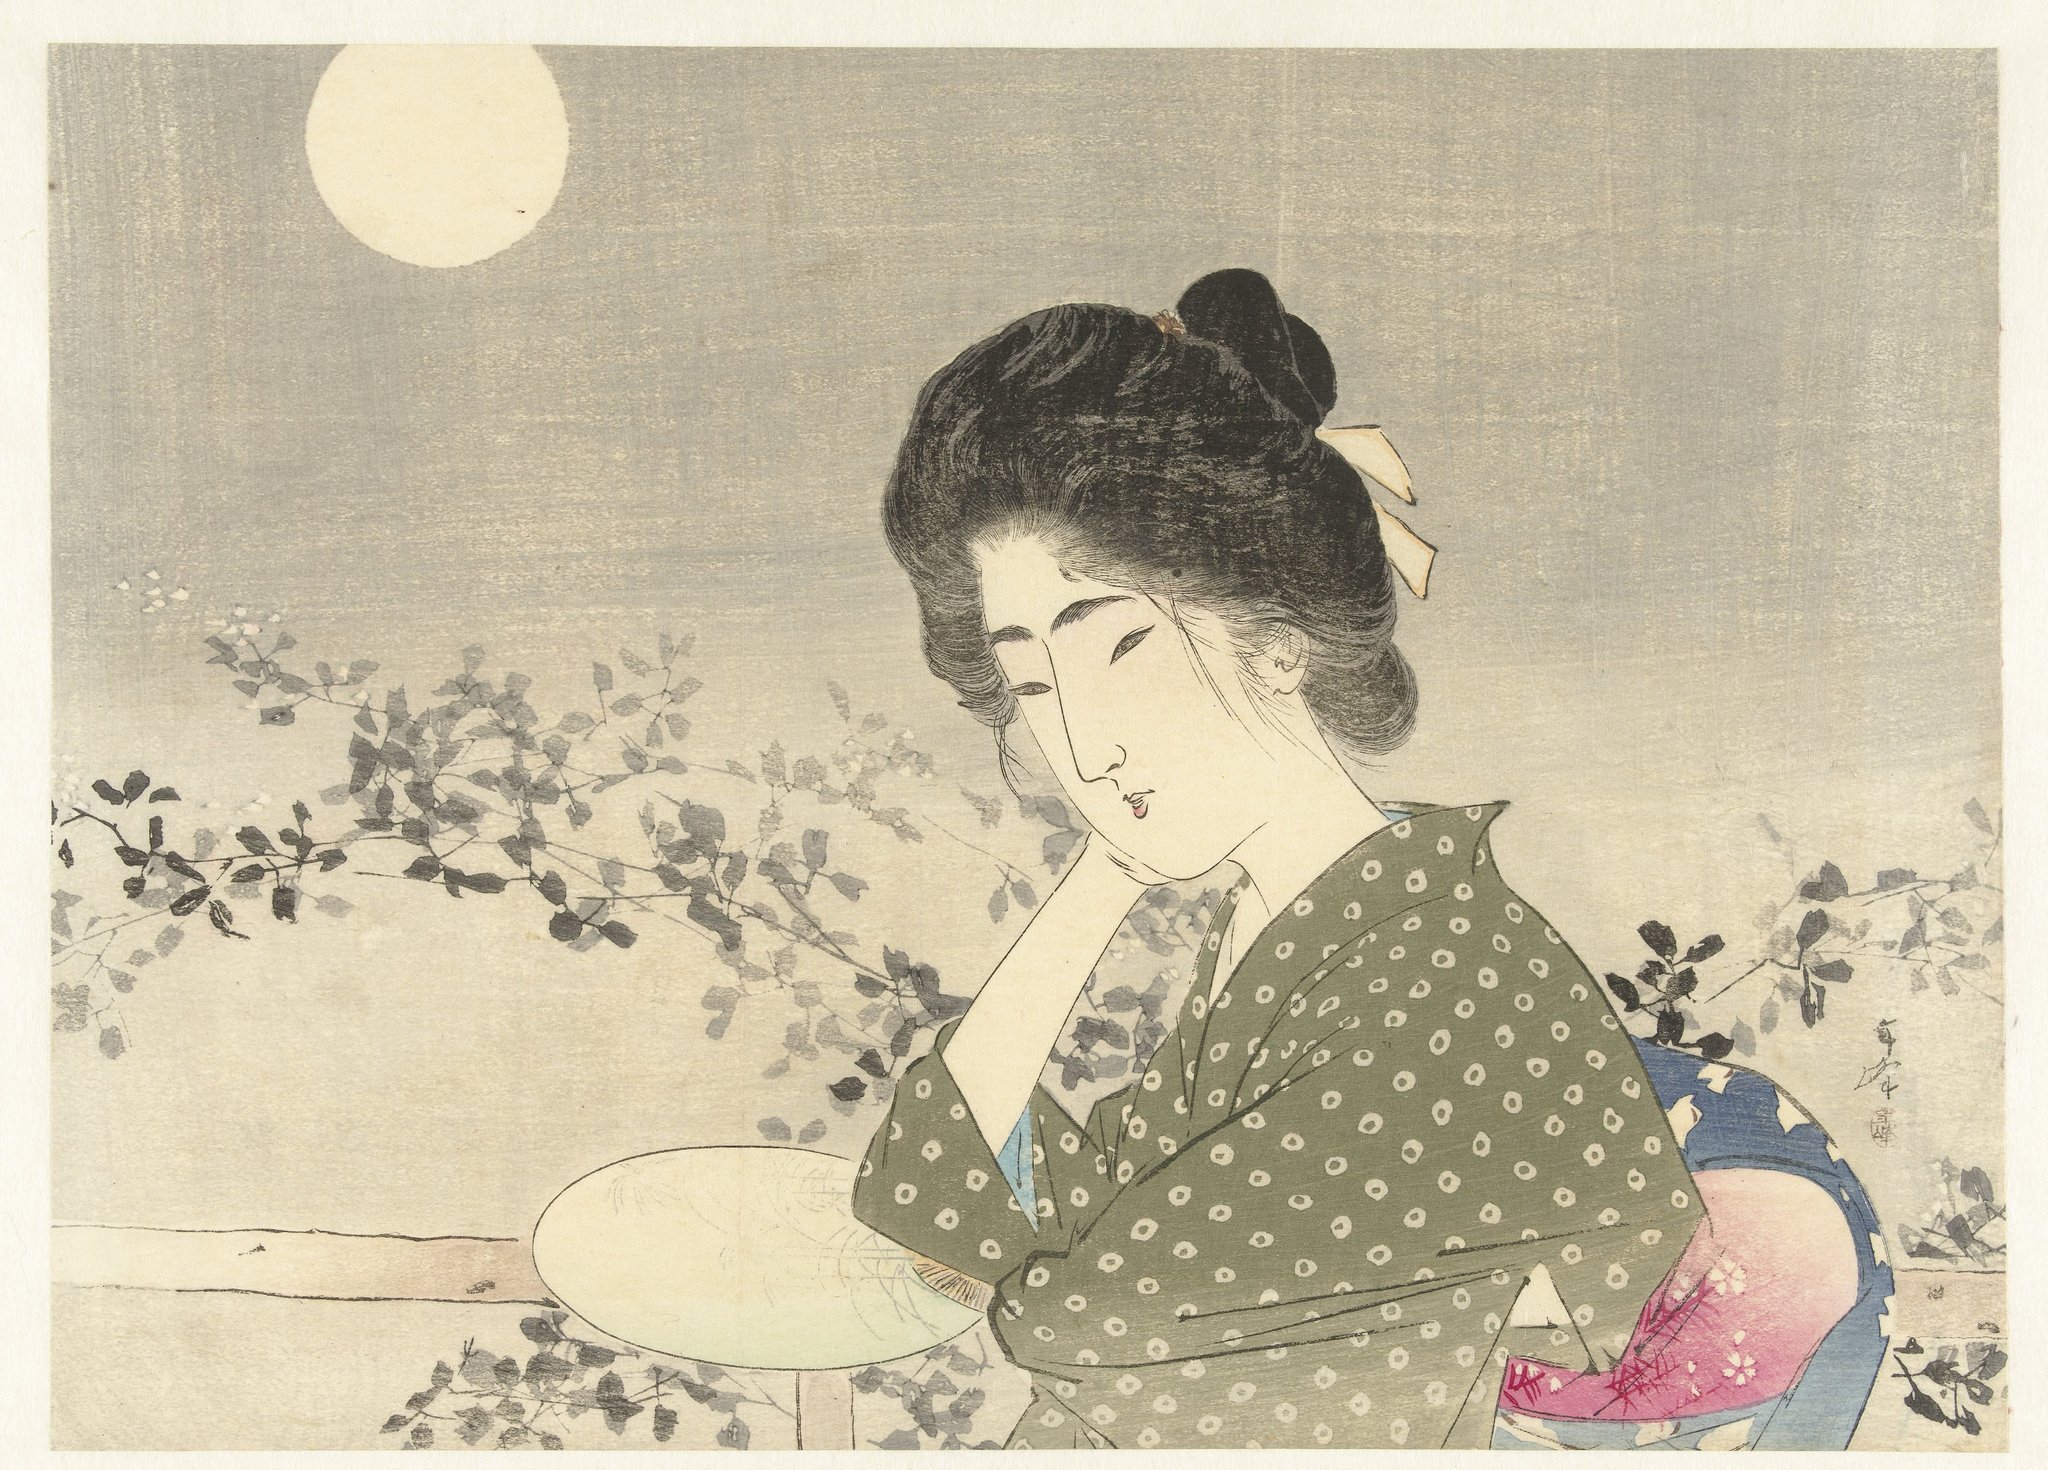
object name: print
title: Vrouw met een waaier bij maanlicht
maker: tsutsui toshimine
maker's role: print maker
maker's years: 1863-1934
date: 1900-1925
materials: paper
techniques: woodcut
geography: japan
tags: plants; vegetation, full moon, adult woman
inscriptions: collector's mark: Lugt 2760, collector's mark: Lugt 2228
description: Vrouw in groene kimono met waaier in de hand, zittend in peinzende houding op een balkon in het maanlicht. Bloesemtakken achter haar.